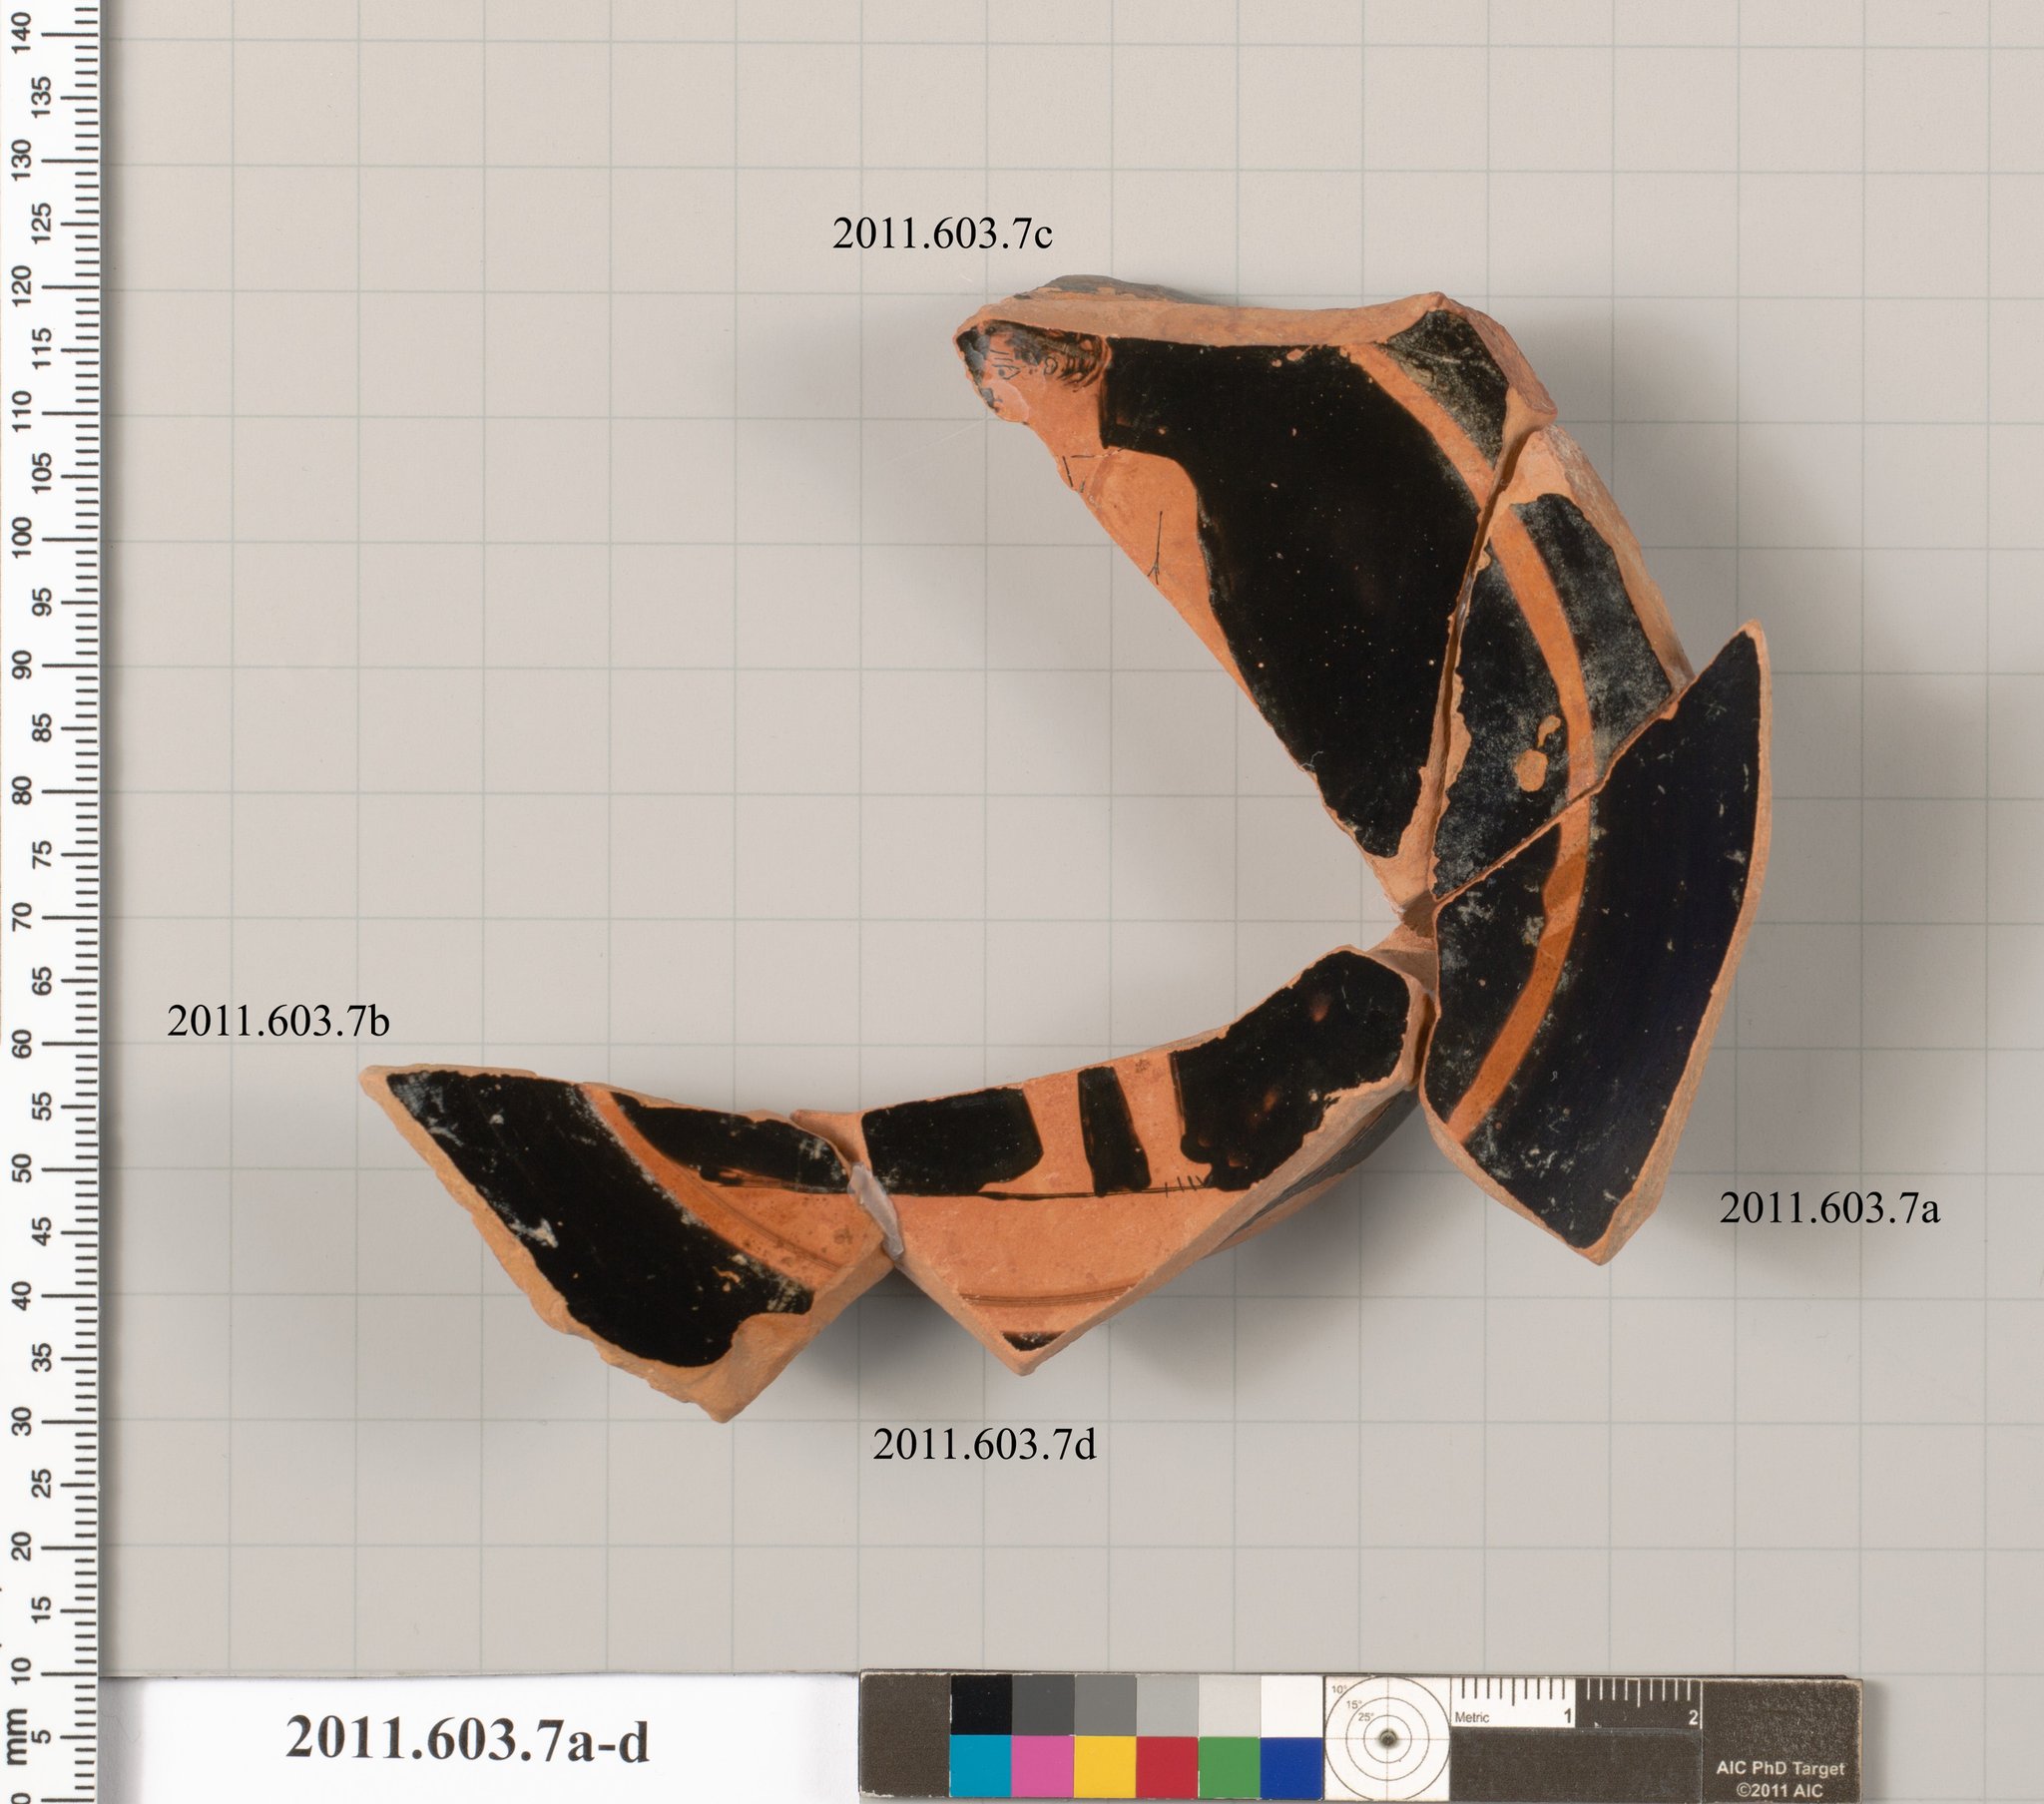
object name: kylix fragment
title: Fragments of a terracotta stemless kylix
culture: greek, attic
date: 467-435 BCE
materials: terracotta